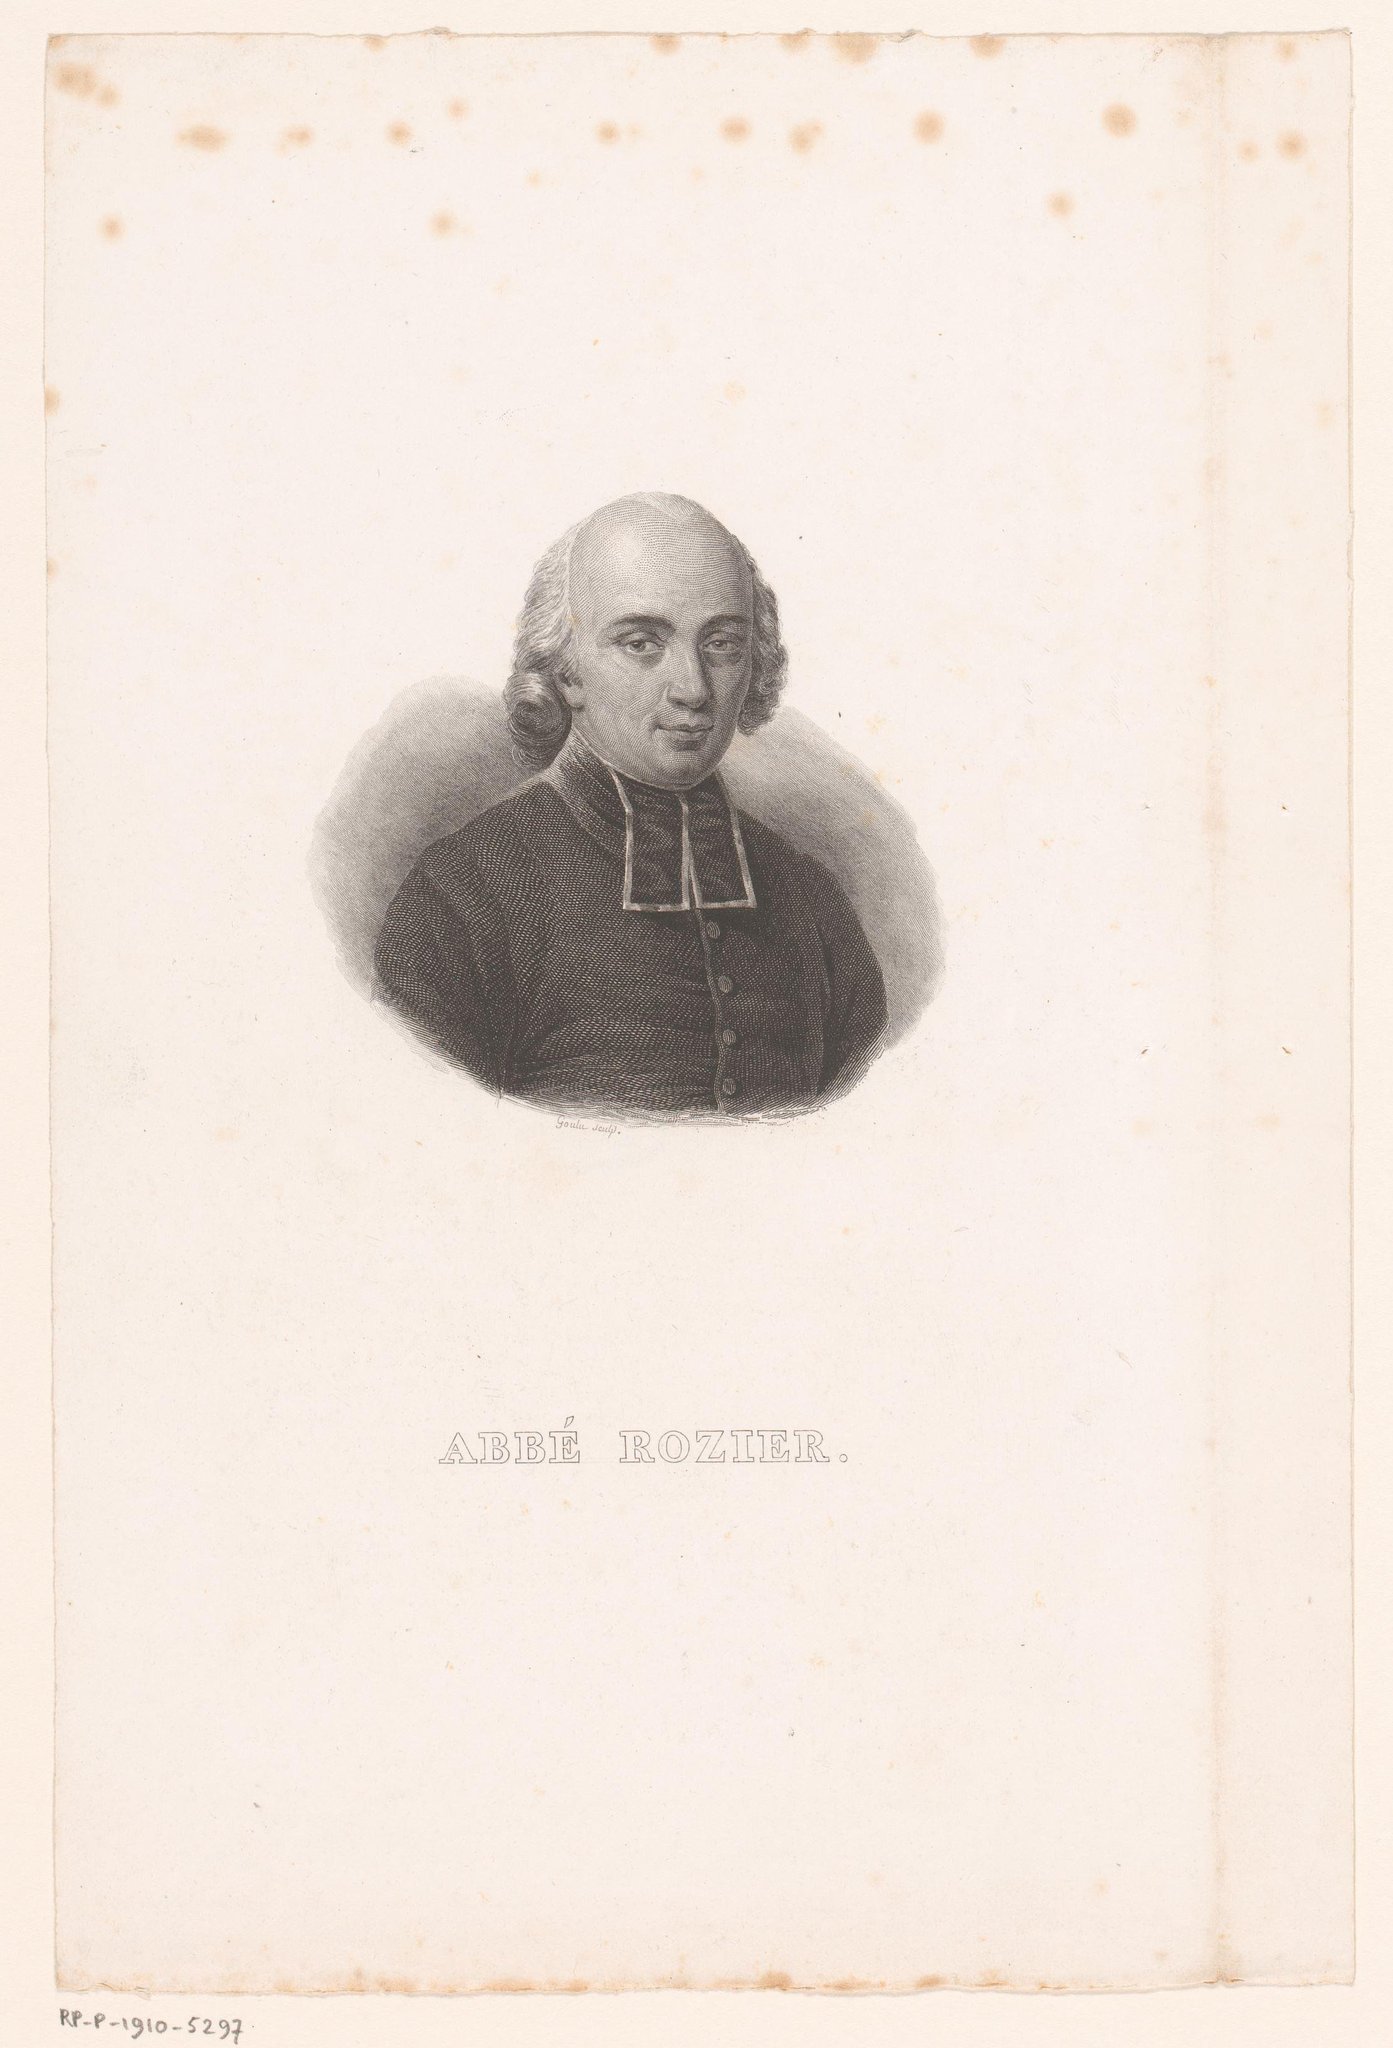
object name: print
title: Portret van François Rozier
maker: ferdinand sébastien goulu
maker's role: print maker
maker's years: 1796-1848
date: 1806-1896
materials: paper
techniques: engraving, etching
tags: lyon, historical persons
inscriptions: collector's mark: Lugt 2228